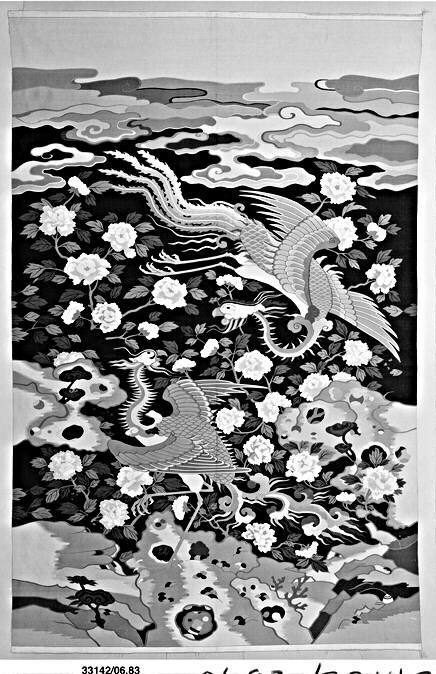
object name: panel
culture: japanese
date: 1801-1900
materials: silk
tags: flowers,leaves